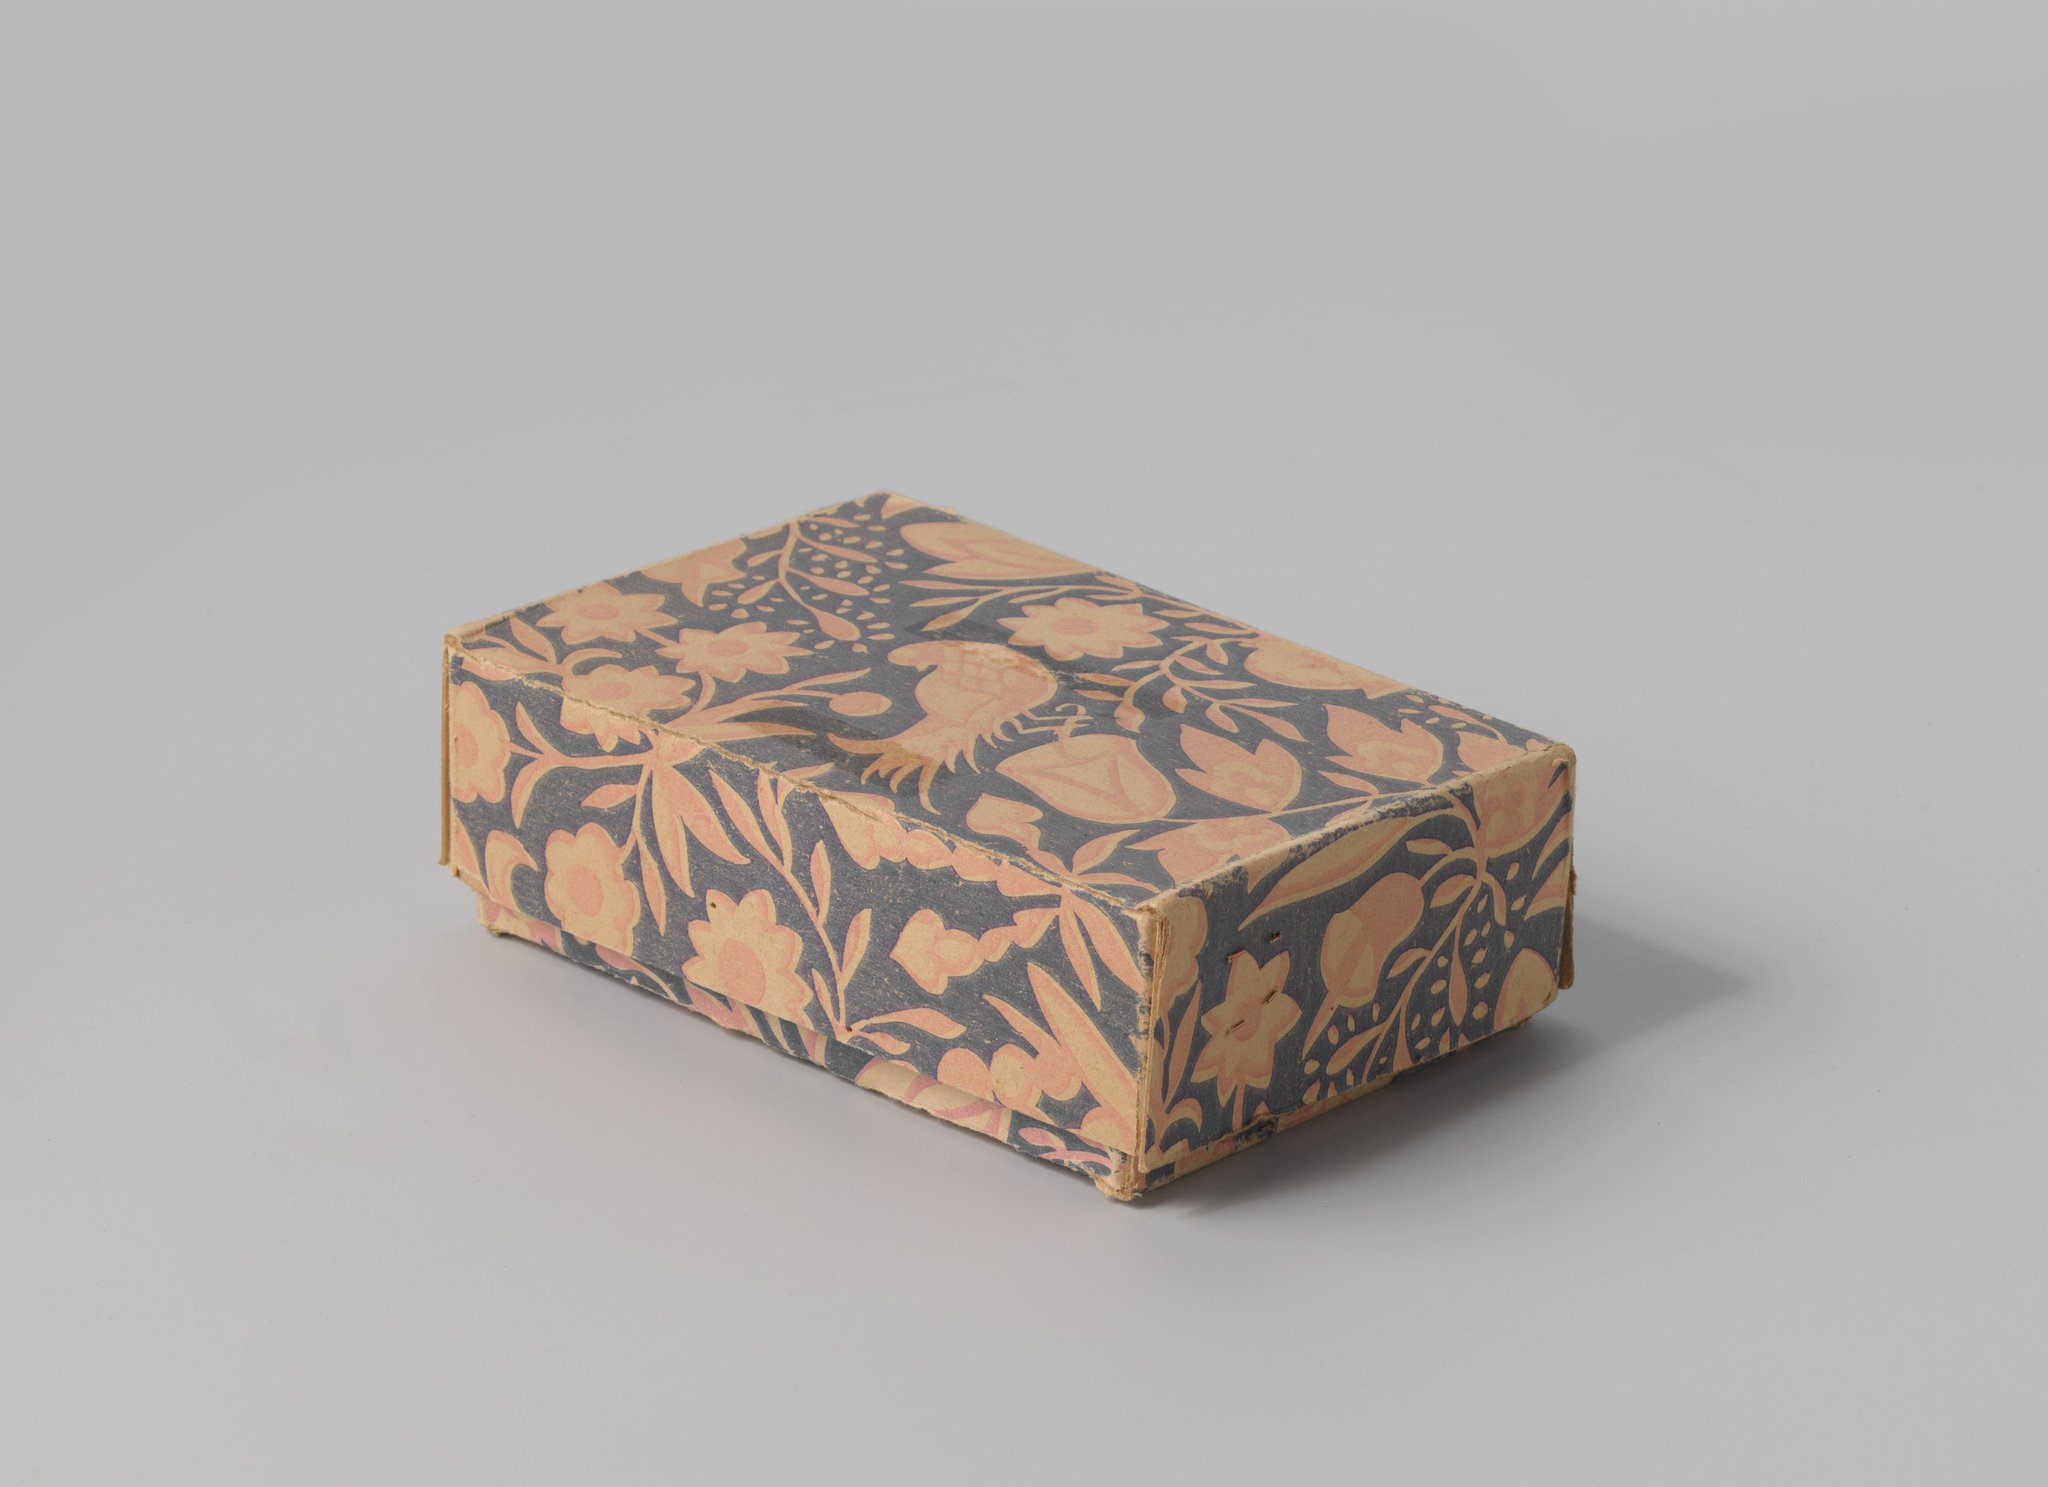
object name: packing material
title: Schoenendoos van paar kinderschoenen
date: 1800-1900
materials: cardboard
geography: paris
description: Rechthoekige kartonnen doos beplakt met met papier waarop flora- en faunamotieven staan afgebeeld. Aan de binnenzijde deksel opdruk van Au Printemps Paris.